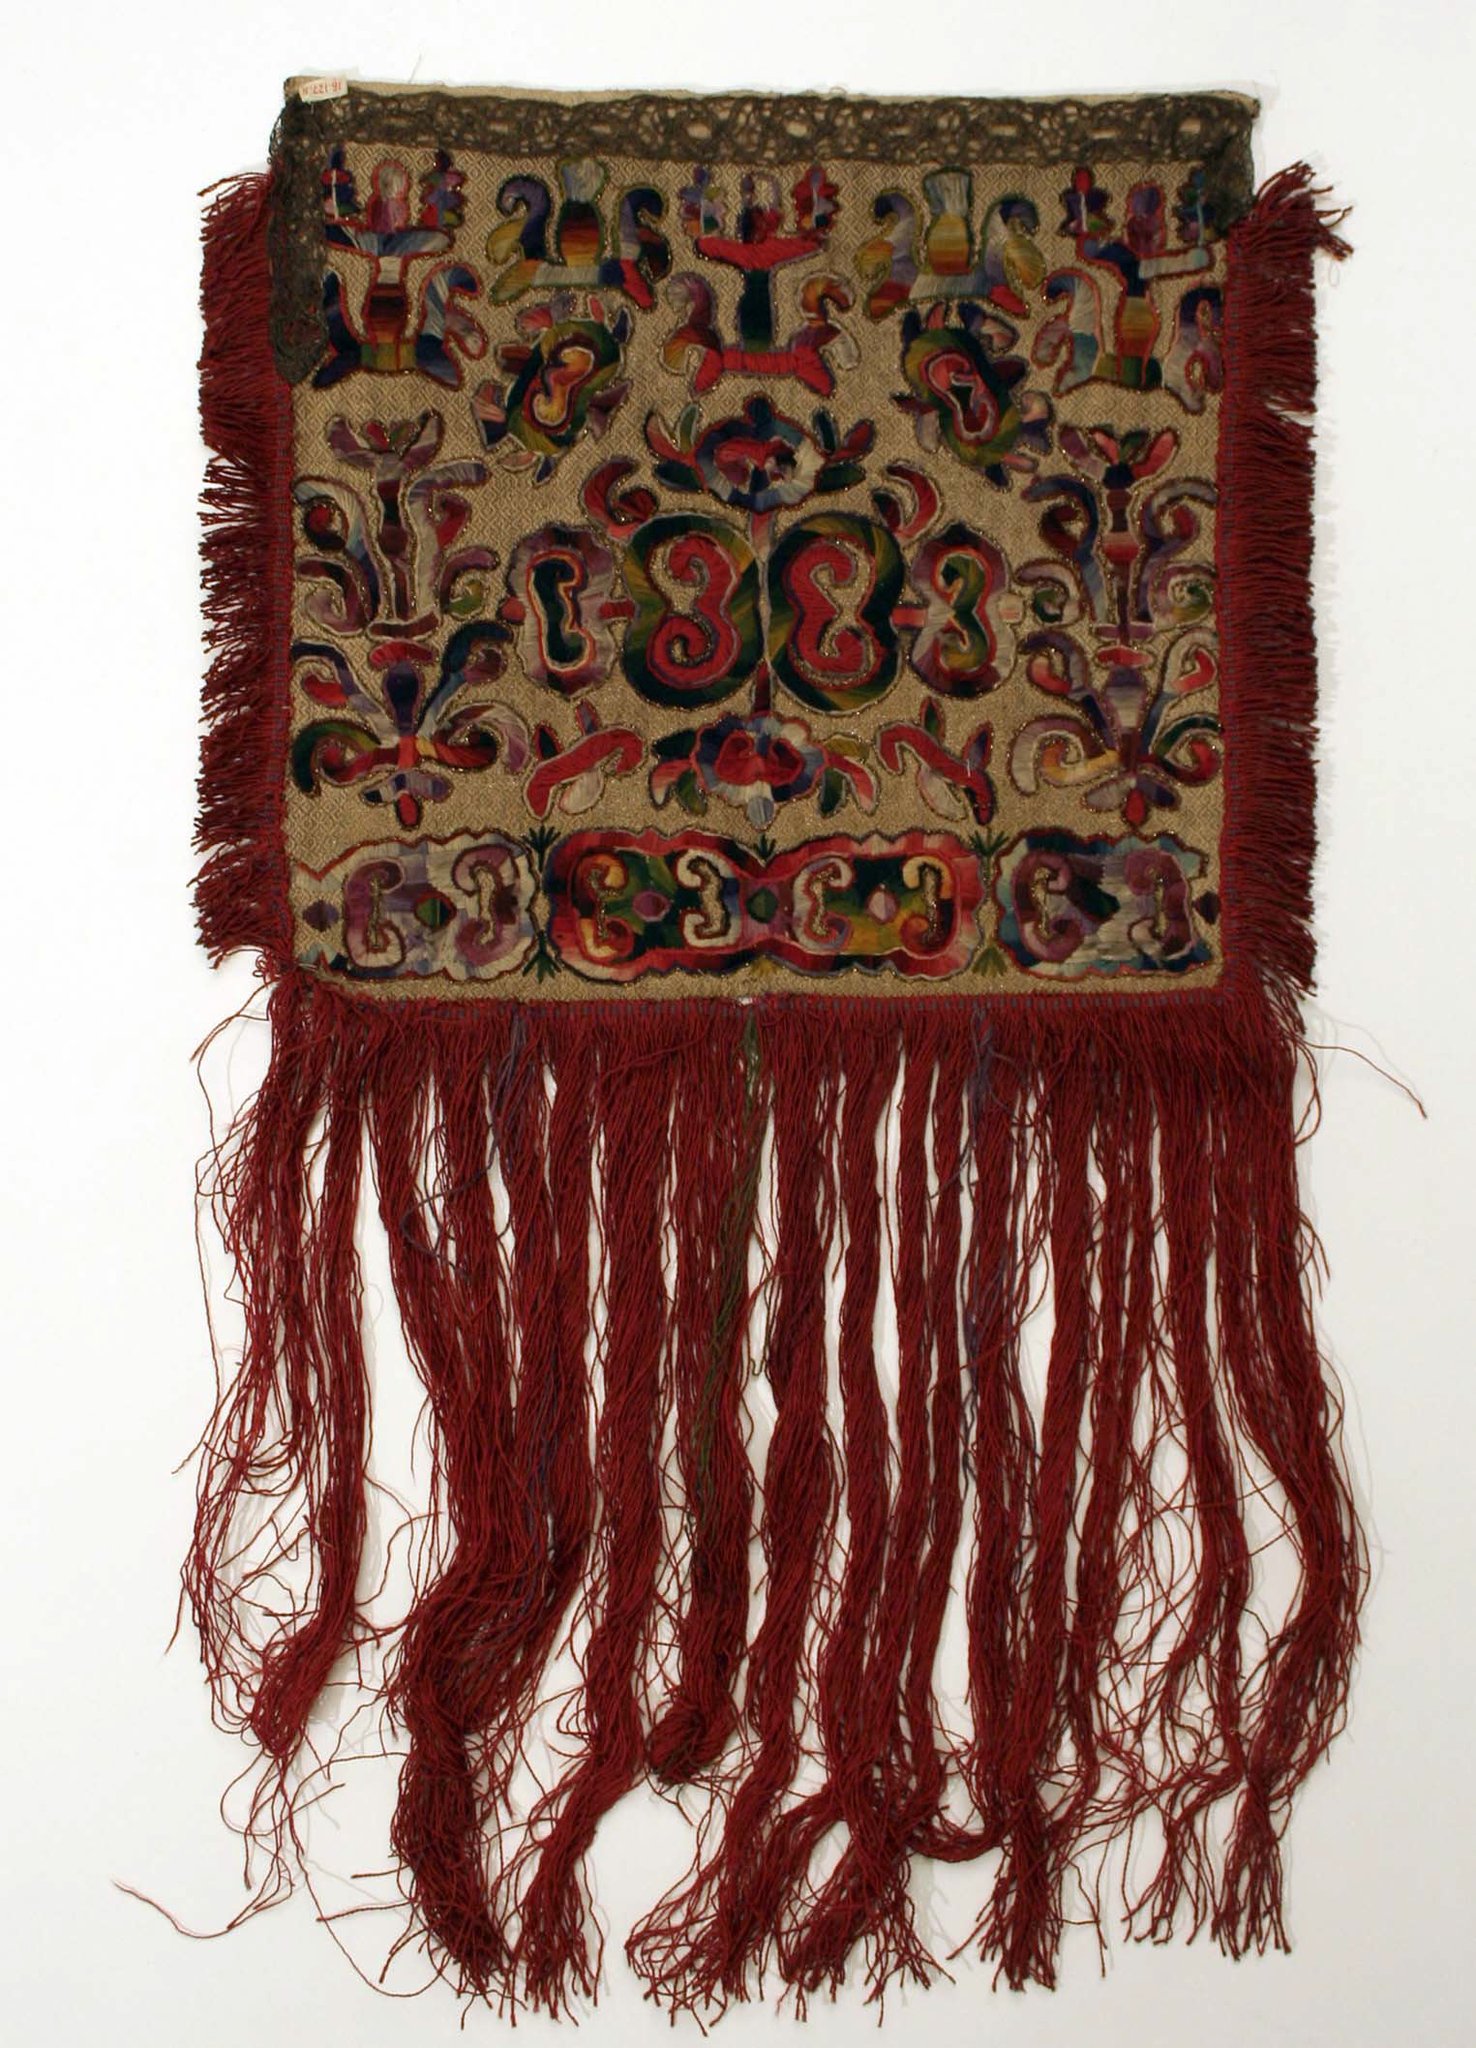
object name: apron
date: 1801-1900